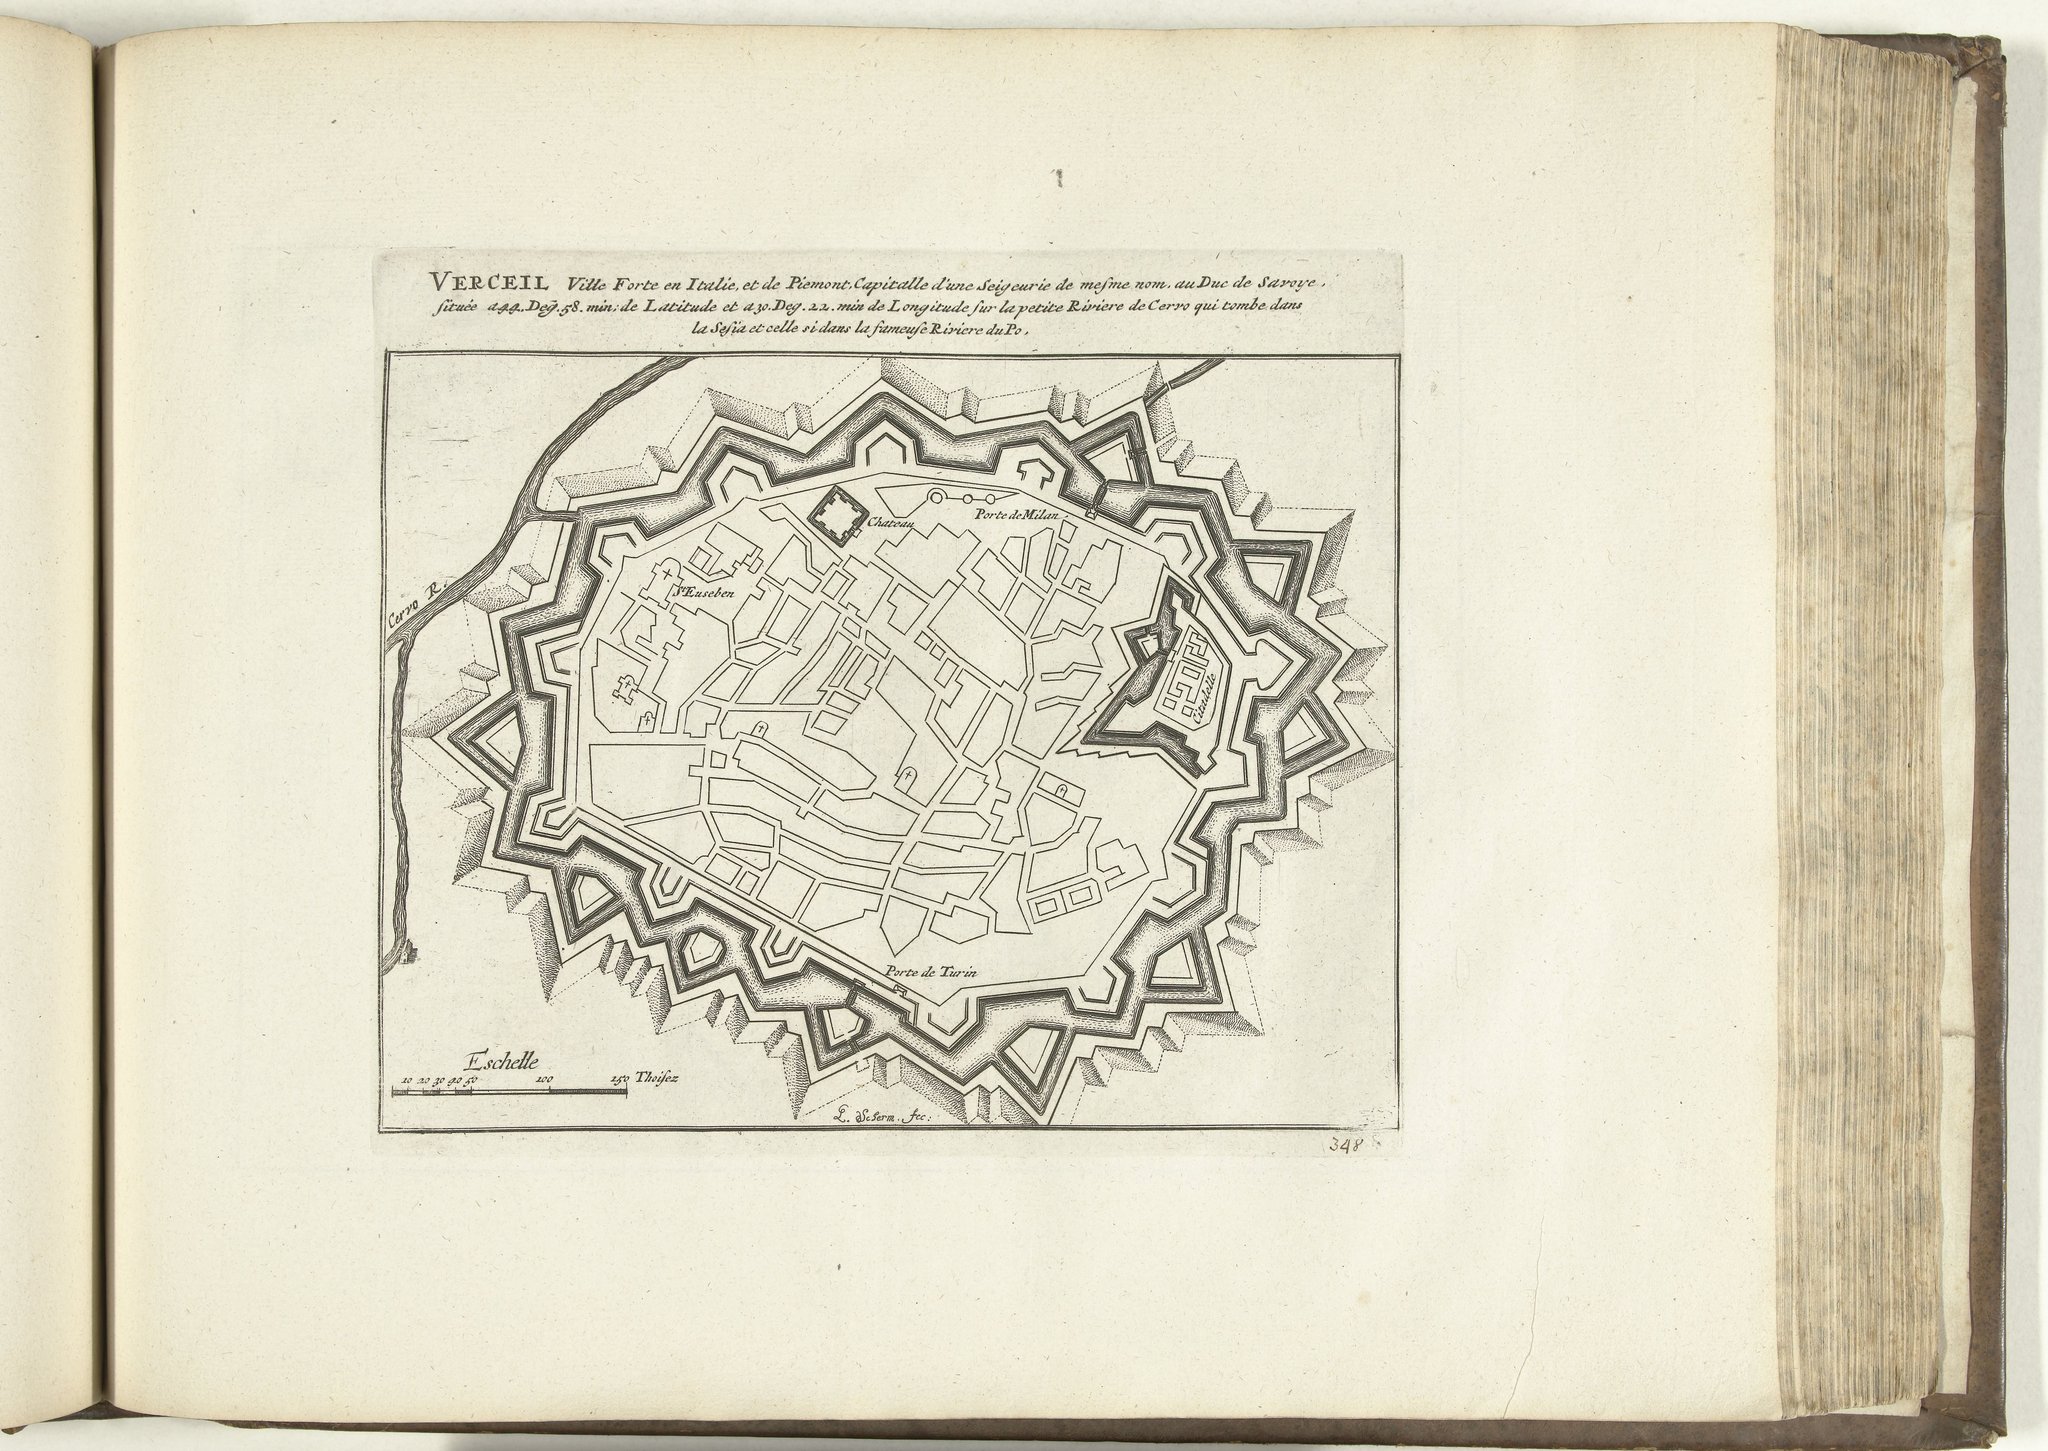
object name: map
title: Verceil Ville Forte en Italie, et de Piemont (...)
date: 1726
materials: paper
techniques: etching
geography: northern netherlands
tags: fortress, maps of cities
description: Plattegrond van de versterkingen om de Italiaanse stad Vercelli (Verceil). Plaat nr. 348 in deel XIV van het prentwerk: Les Forces de l'Europe, Asie, Afrique et Amerique ... Comme aussi les Cartes des Côtes de France et d'Espagne uit 1726, dit tweede deel met 271 met de hand genummerde platen van vermaarde sterke steden en vestingen in het kader van de Spaanse Successieoorlog 1701-1713. Voor het merendeel zijn deze platen gekopieerd naar de anonieme Franse platen van vermaarde sterke steden en vestingen: in Les forces de l'Europe en in: Le theatre de la guerre, dans les Pays-Bas, beide oorspronkelijk uitgegeven door Nicolas de Fer te Parijs (1693-1697) in het kader van de Negenjarige Oorlog. Titel en opschriften in het Frans. Rechtsonder sporen van het weggepolijste nummer: 176.